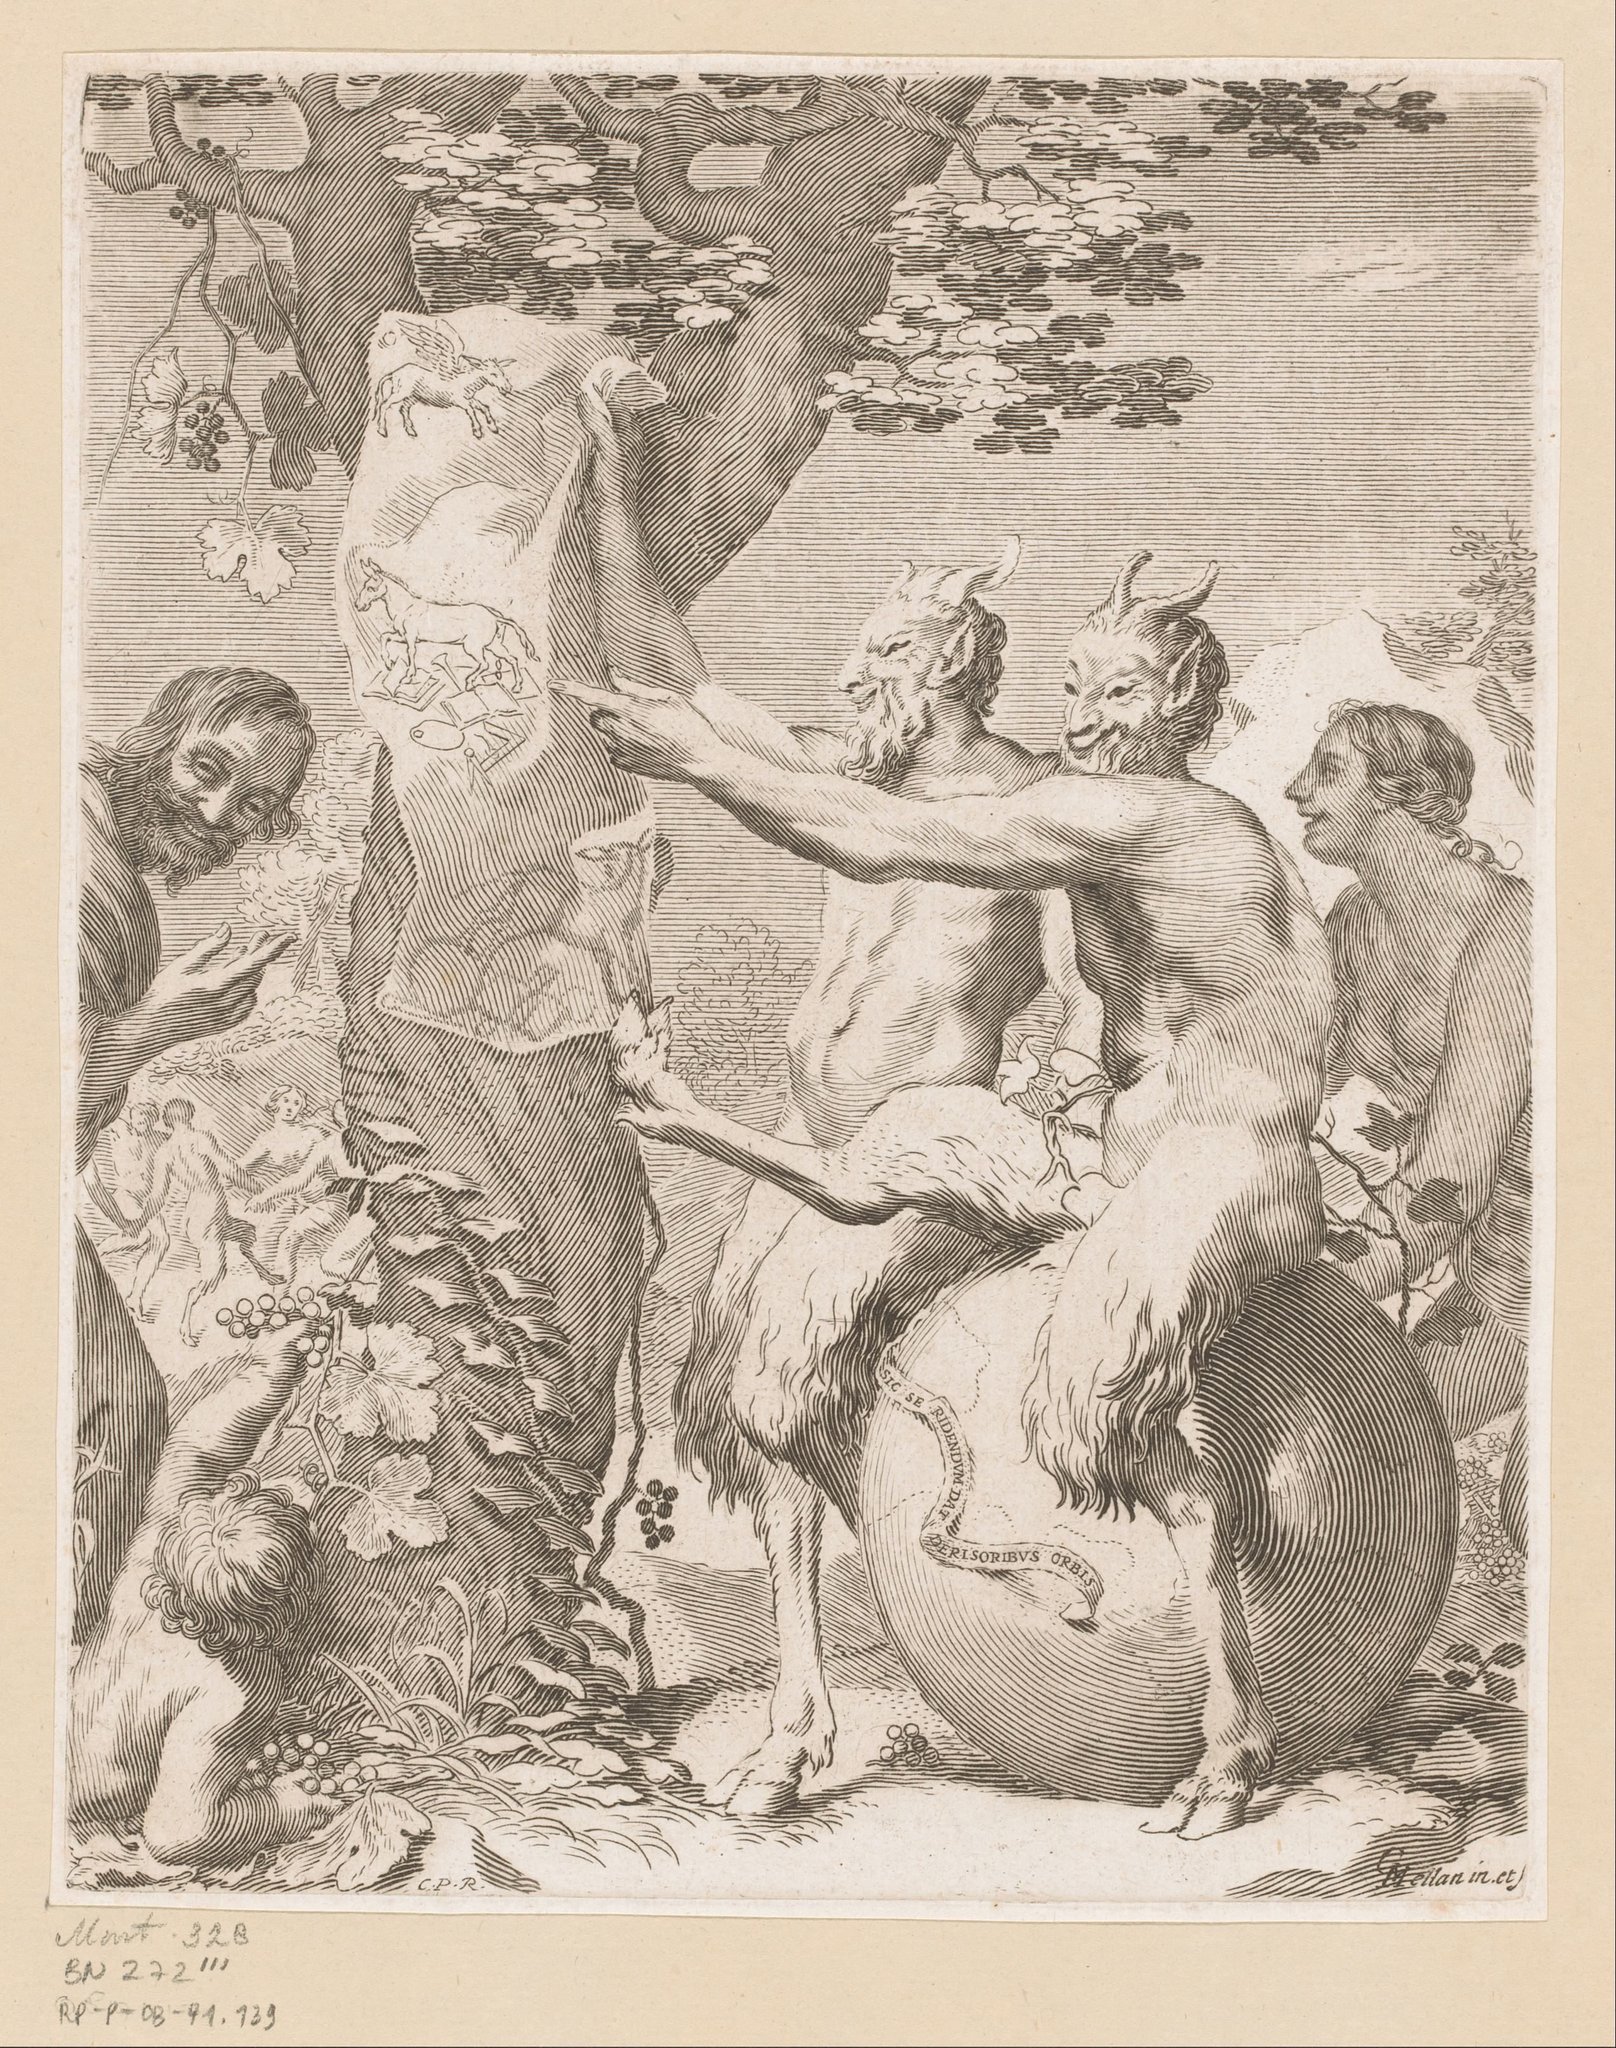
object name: print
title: Saters spottend met een tekening op een boom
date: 1636-1645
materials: paper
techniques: engraving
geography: france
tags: mocking, insulting; teasing, satyr(s) (in general), globe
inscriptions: collector's mark: Lugt 240